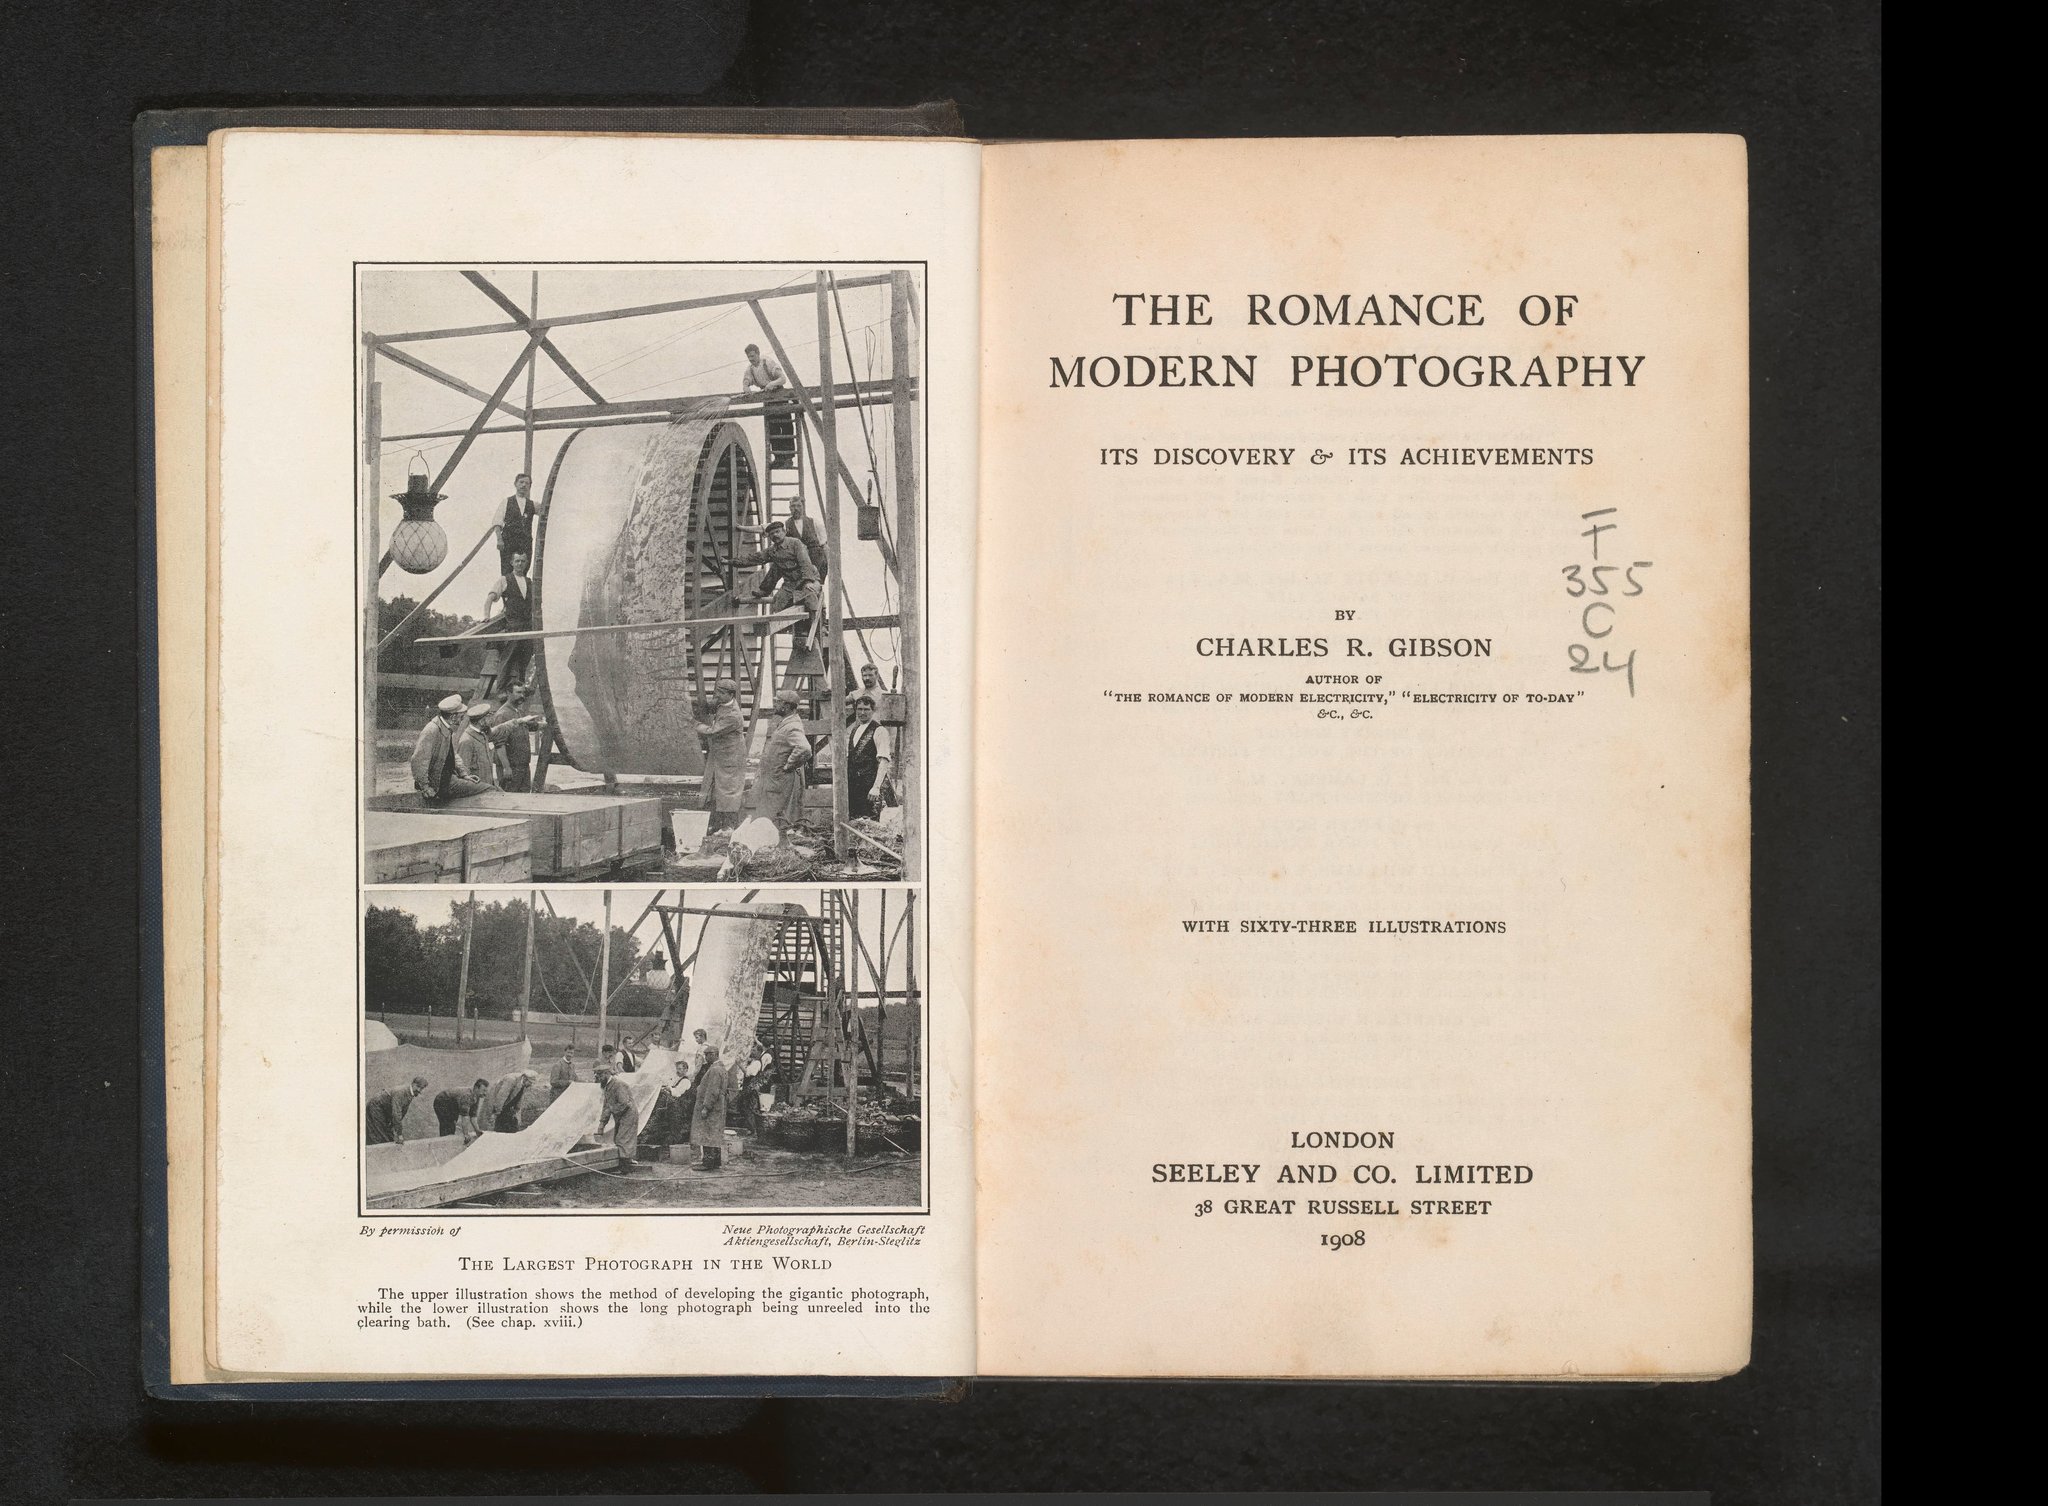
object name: book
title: The romance of modern photography its discovery and its achievements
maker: charles r. gibson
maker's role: schrijver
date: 1908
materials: cardboard, linen, paper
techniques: printing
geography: london